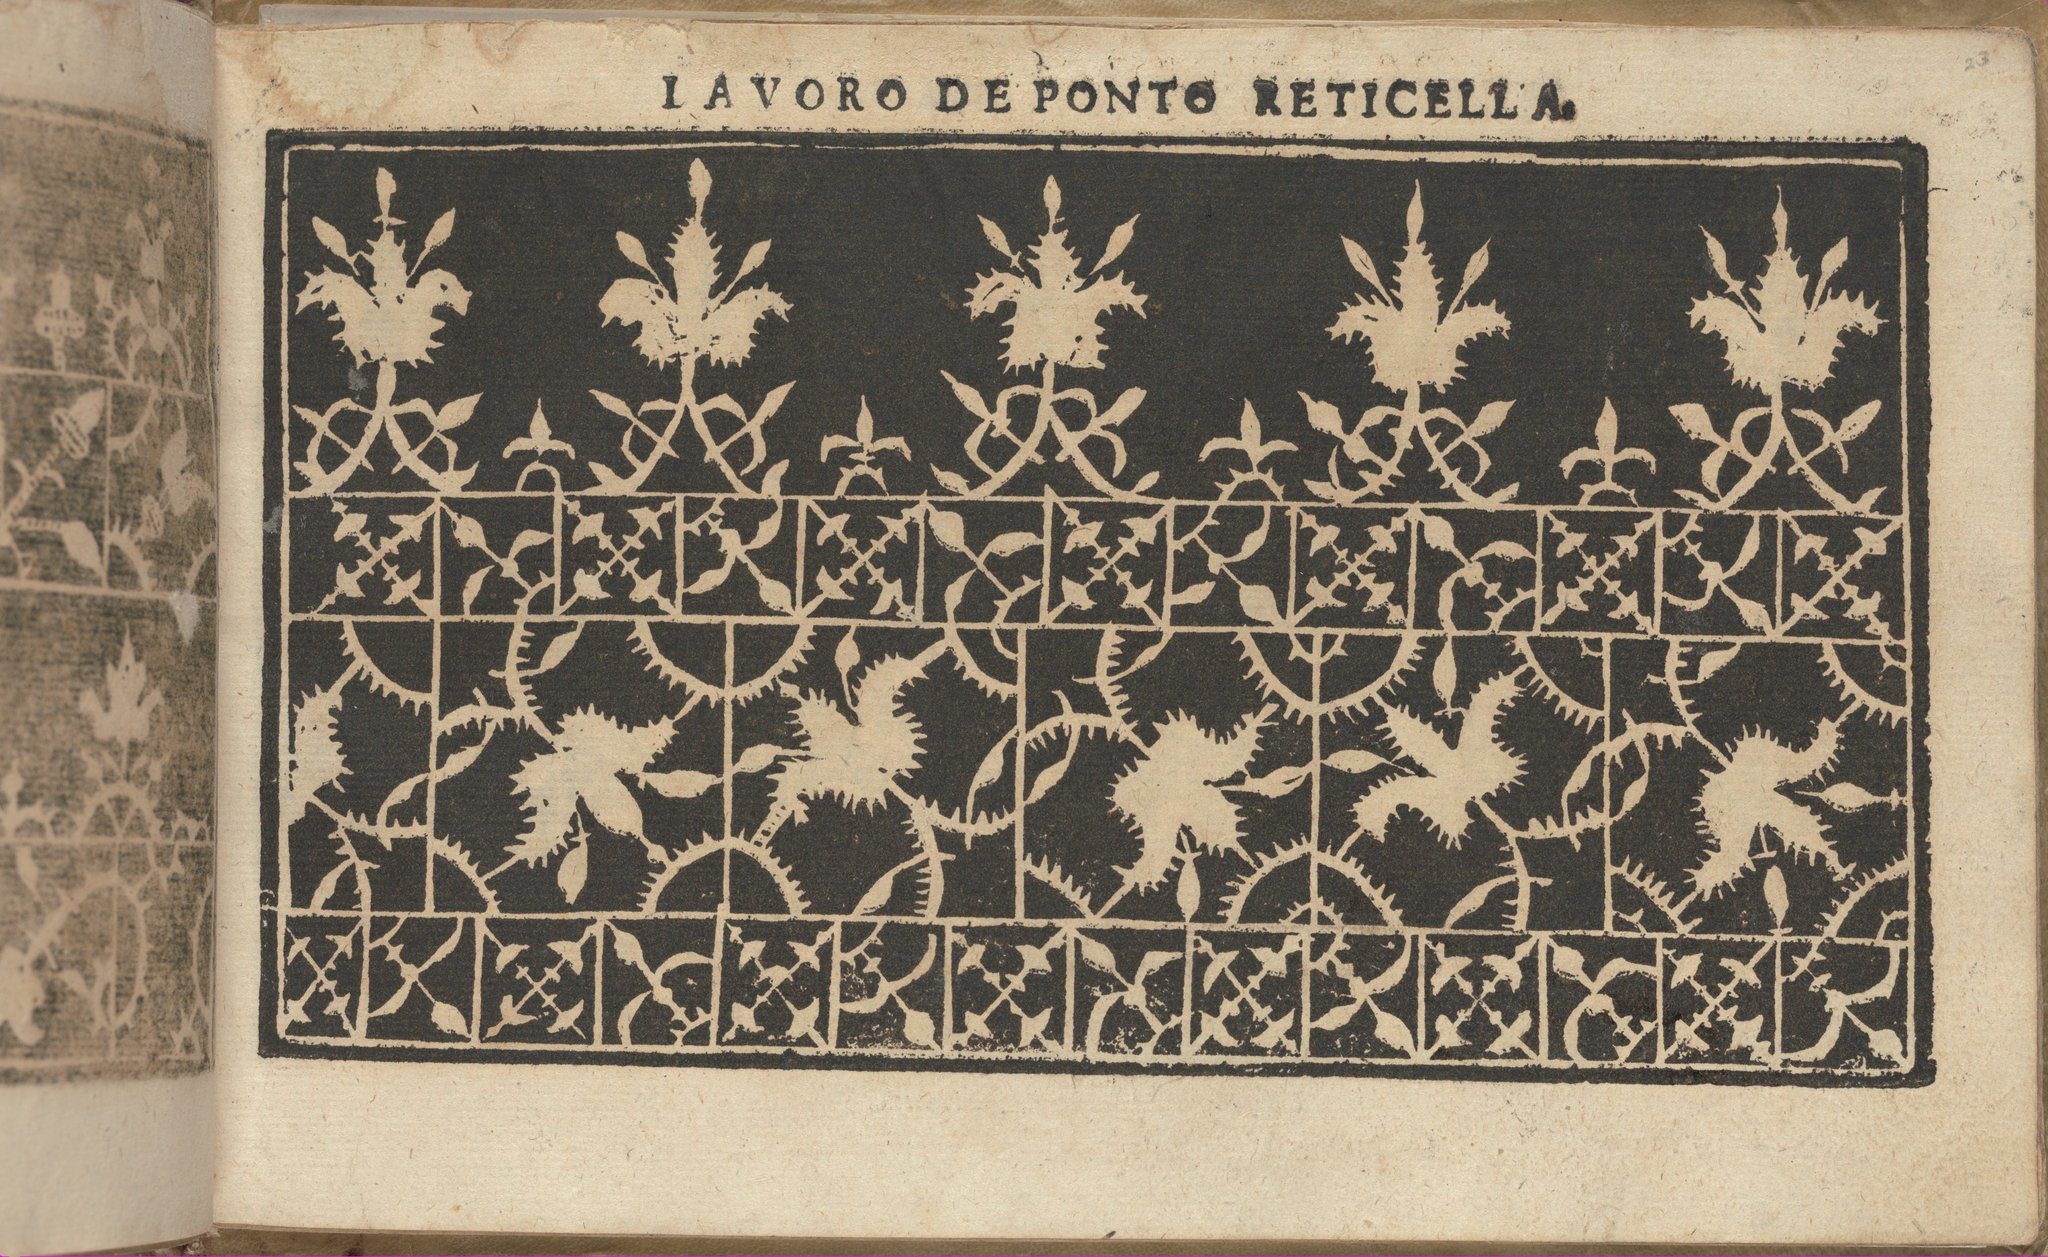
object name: book print ornament architecture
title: Studio delle virtuose Dame, page 23 (recto)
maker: isabella catanea parasole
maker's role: designer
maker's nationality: italian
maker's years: 1565-1625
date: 1597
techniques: woodcut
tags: ornament